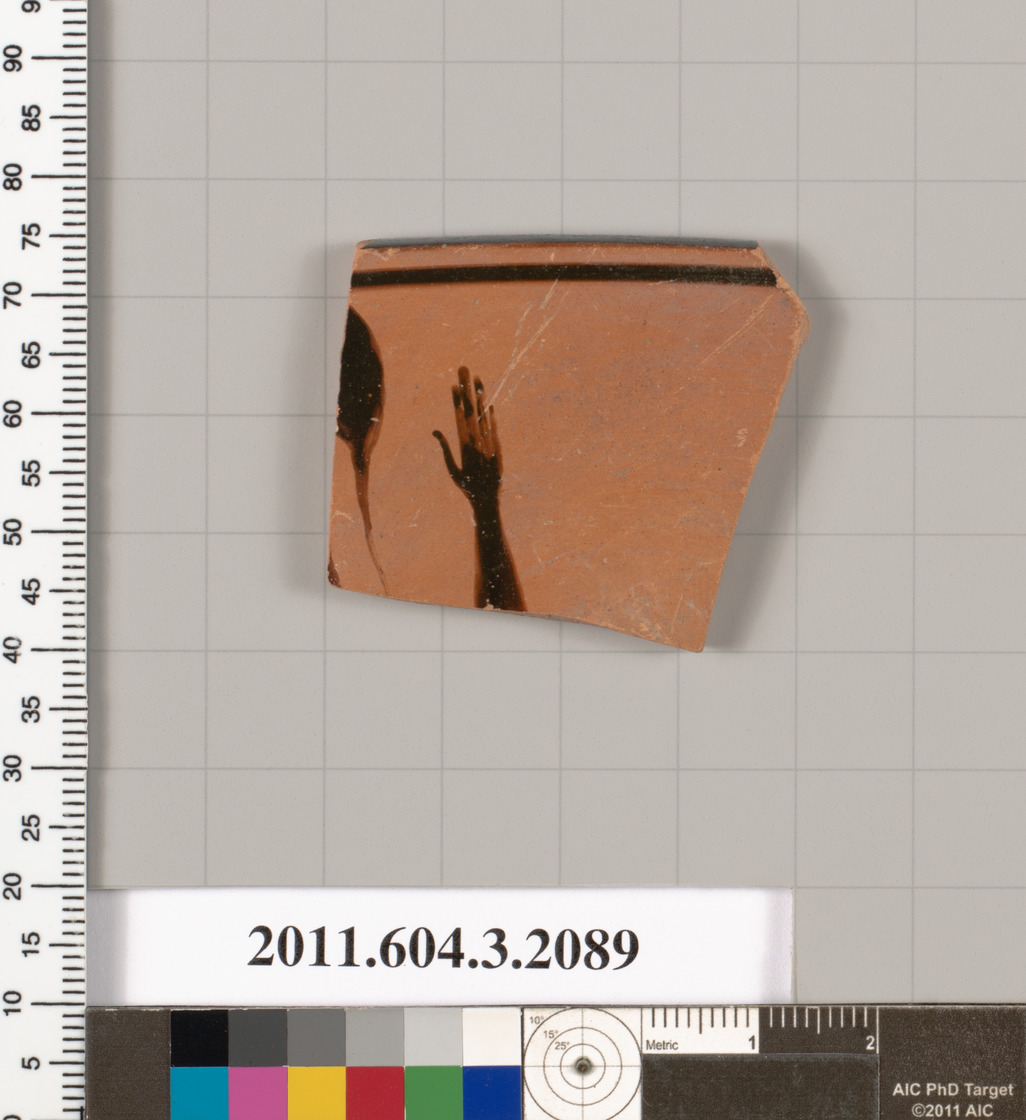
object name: kylix fragment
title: Terracotta rim fragment of a kylix (drinking cup)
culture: greek, attic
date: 534-468 BCE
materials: terracotta